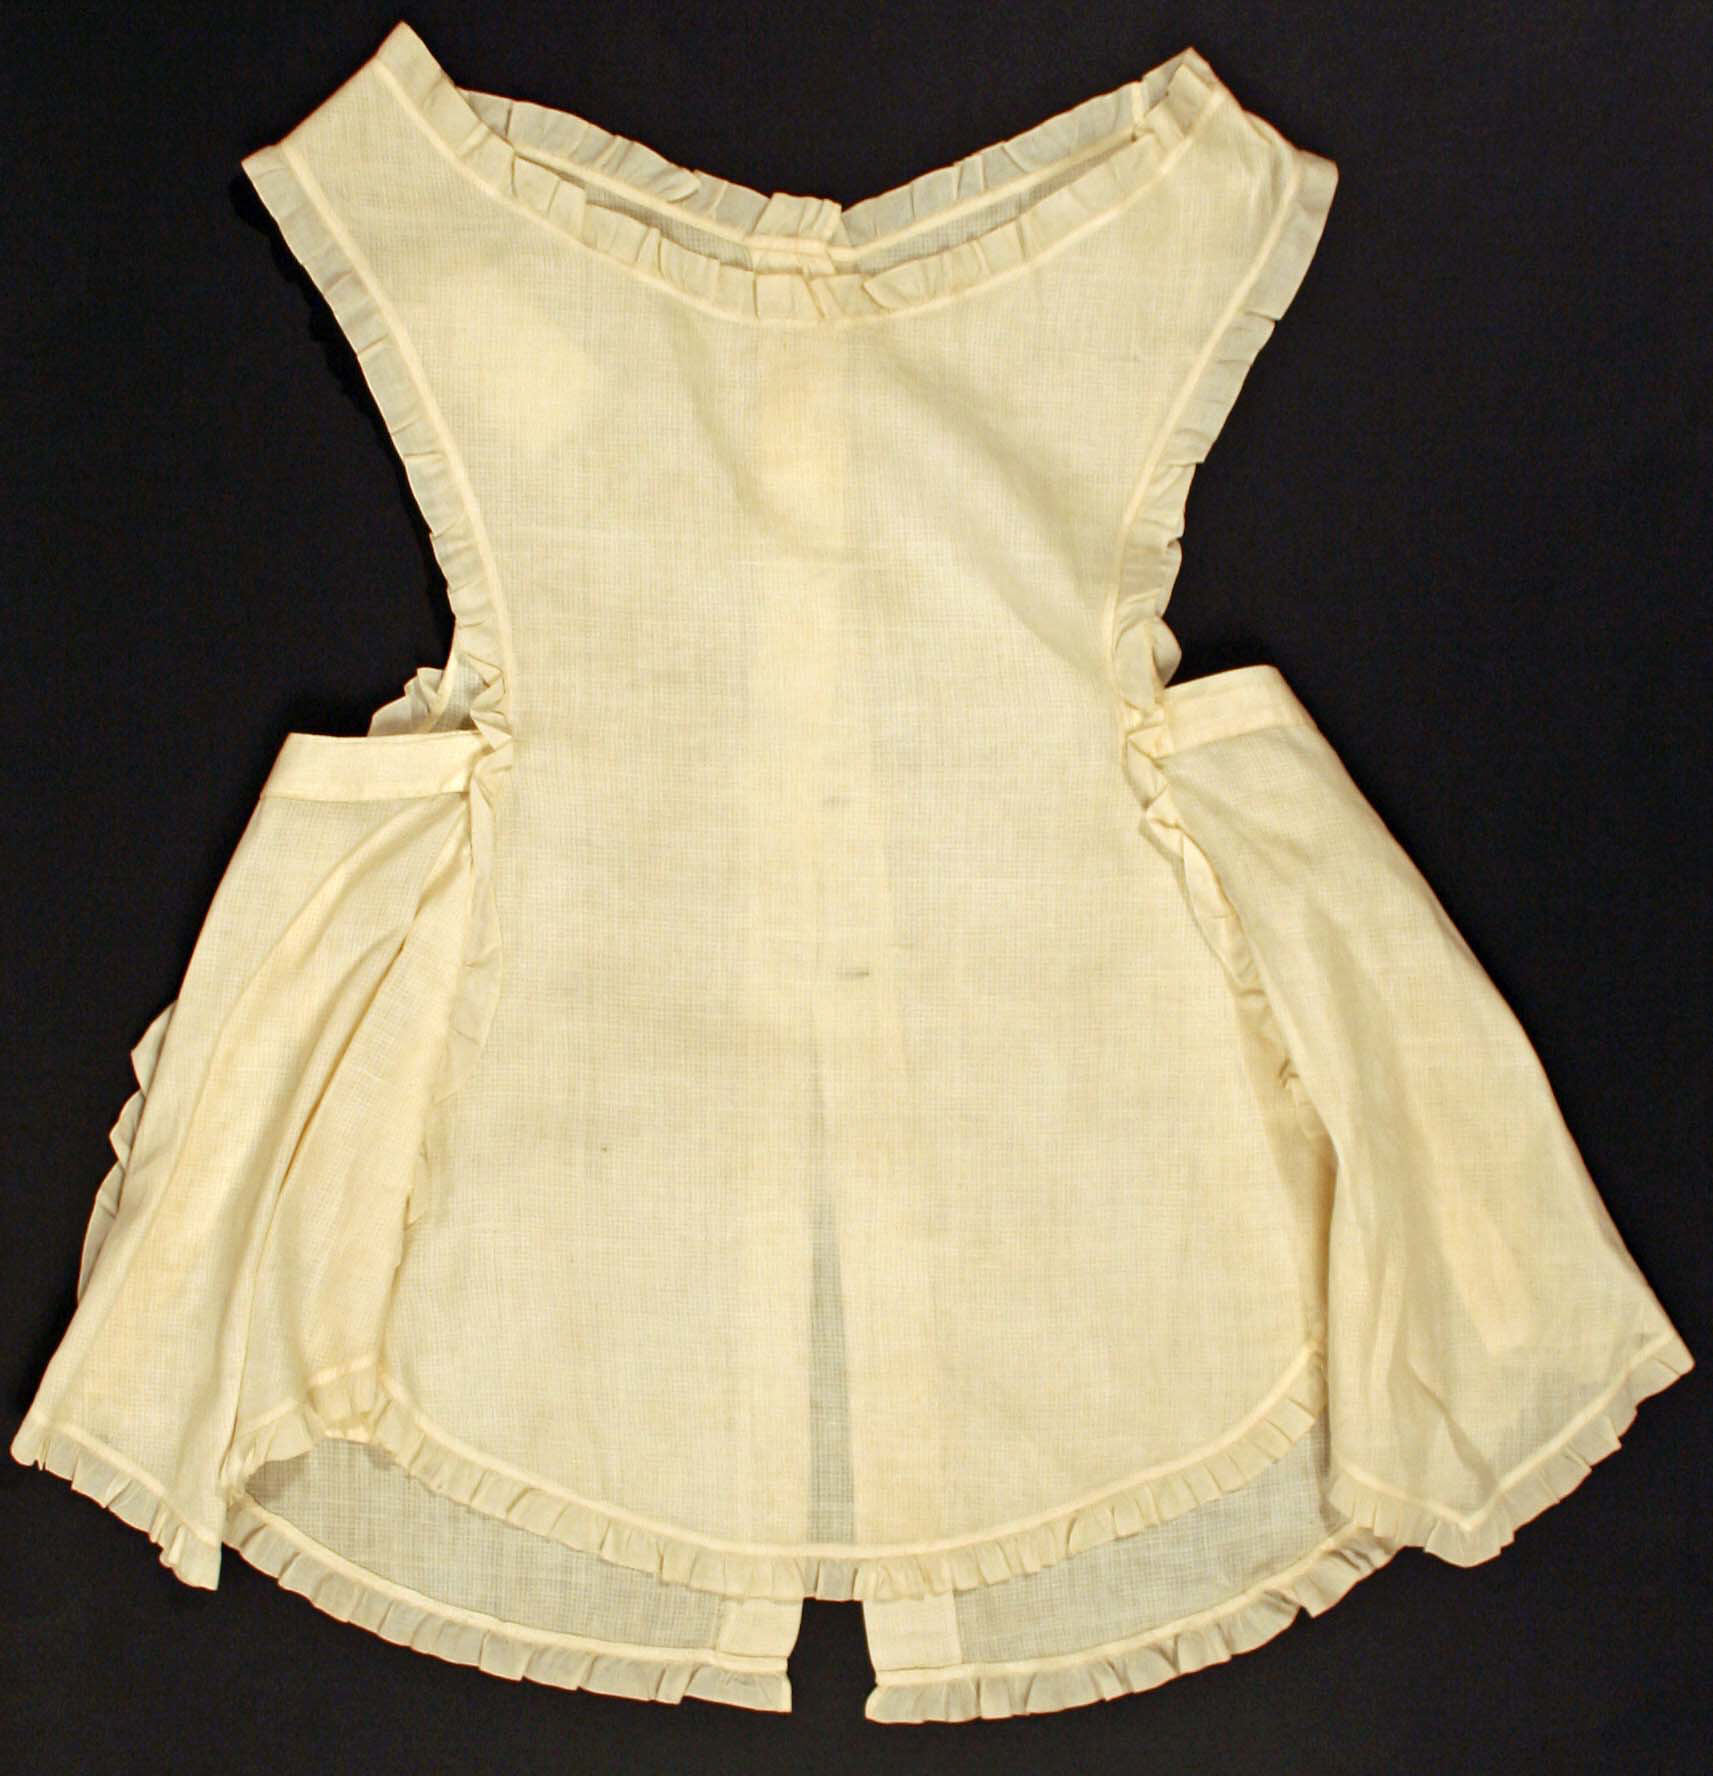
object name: pinafore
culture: american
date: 1871-1873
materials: cotton